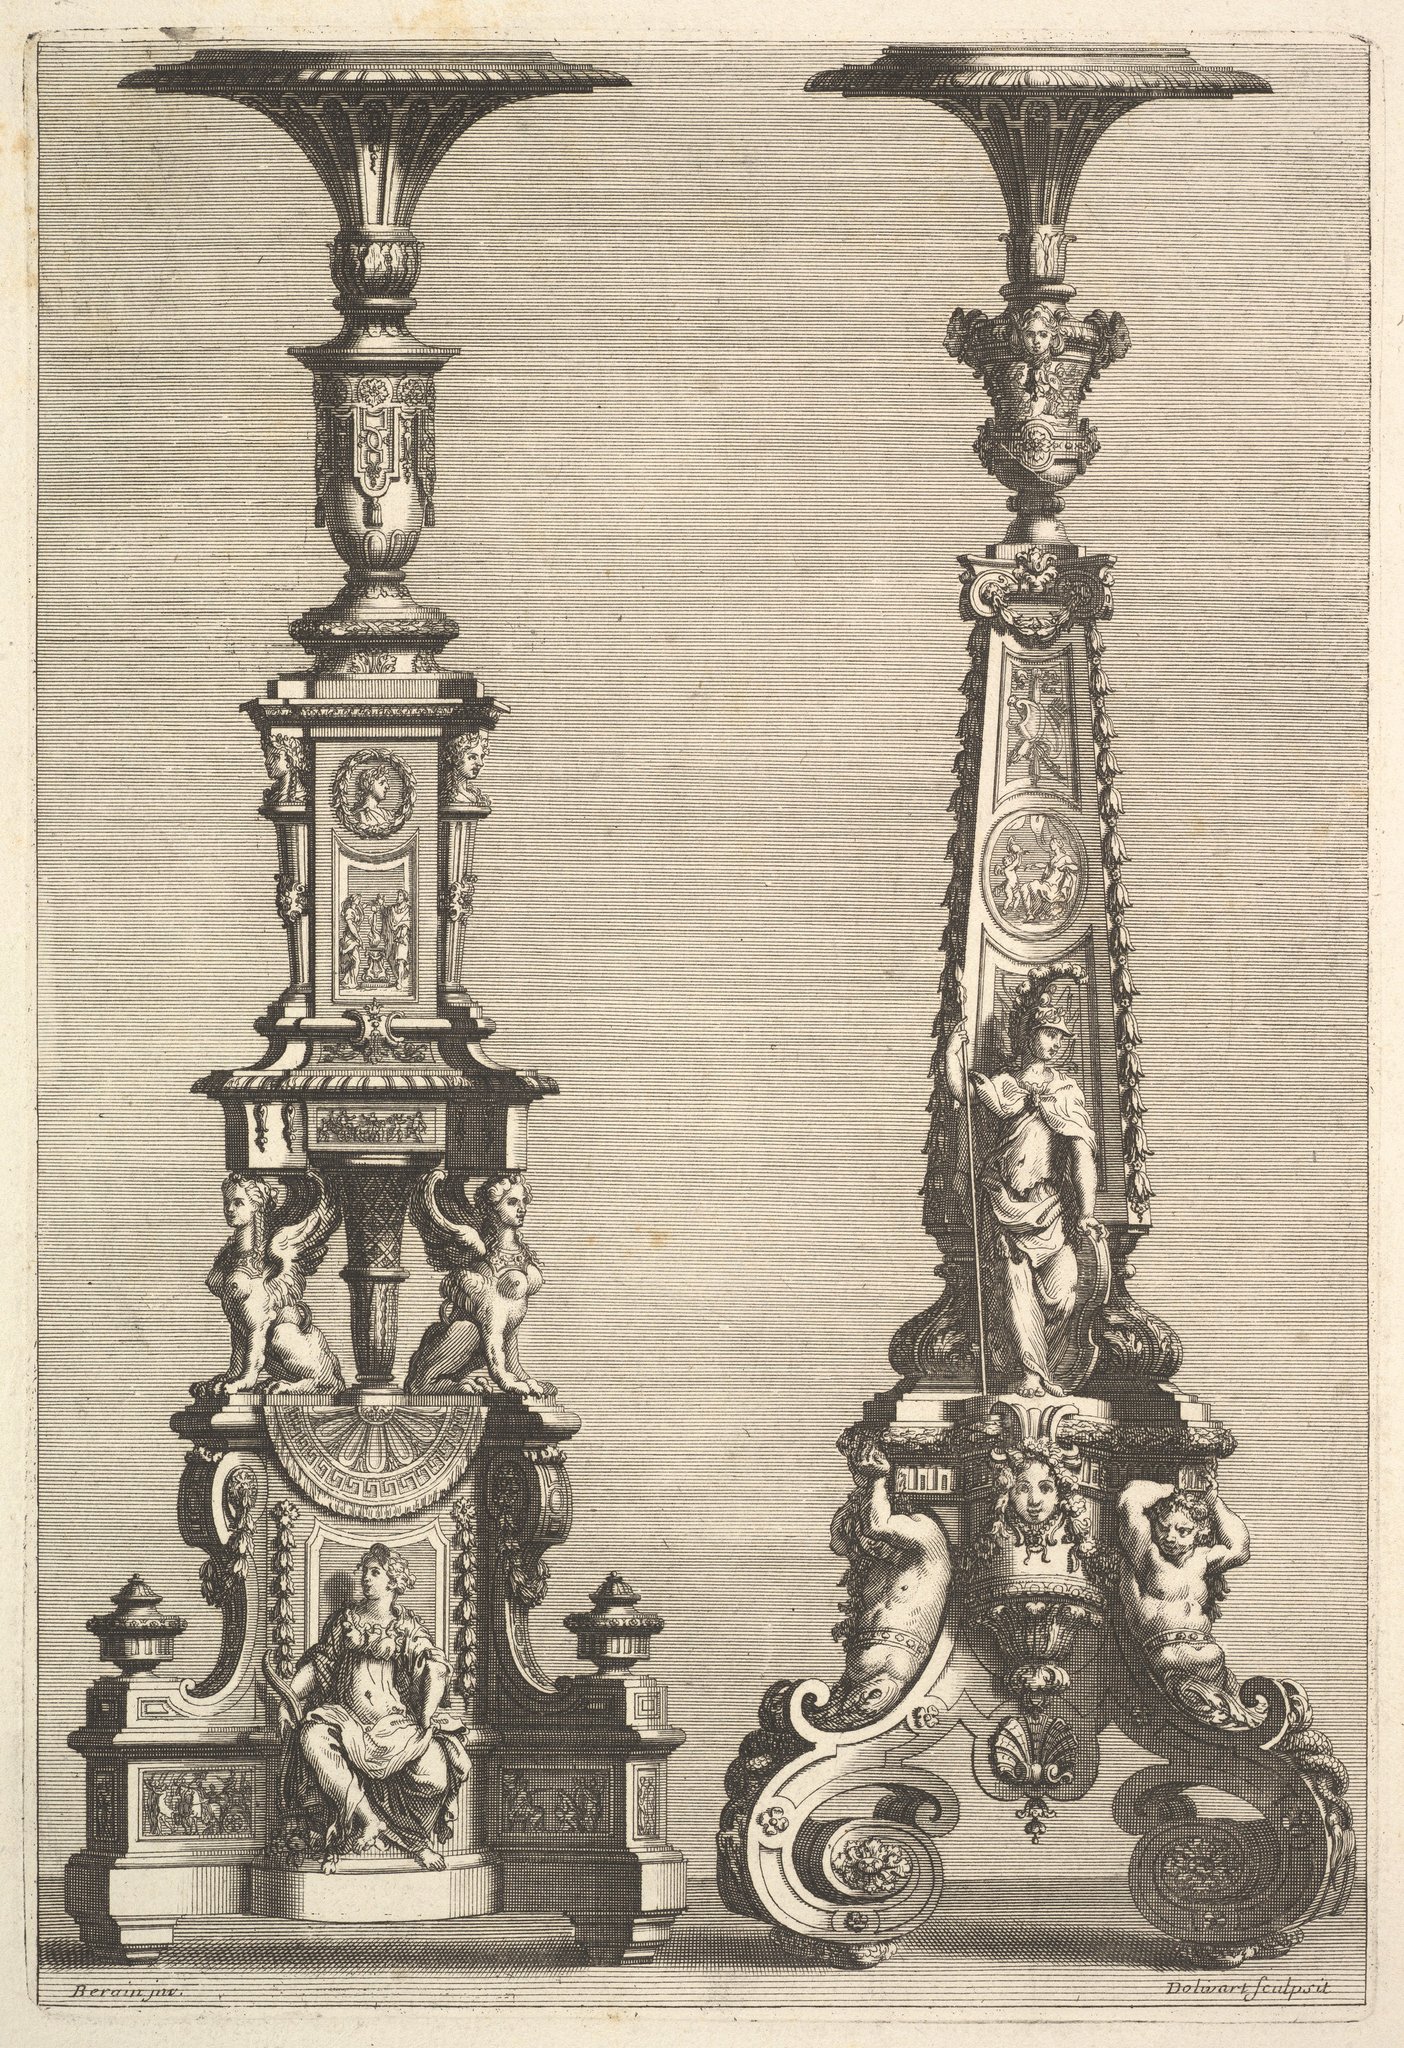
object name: print ornament architecture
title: Two Torchères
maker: juan dolivar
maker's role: artist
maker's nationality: spanish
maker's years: 1641-1692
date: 1692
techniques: engraving, etching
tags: lighting